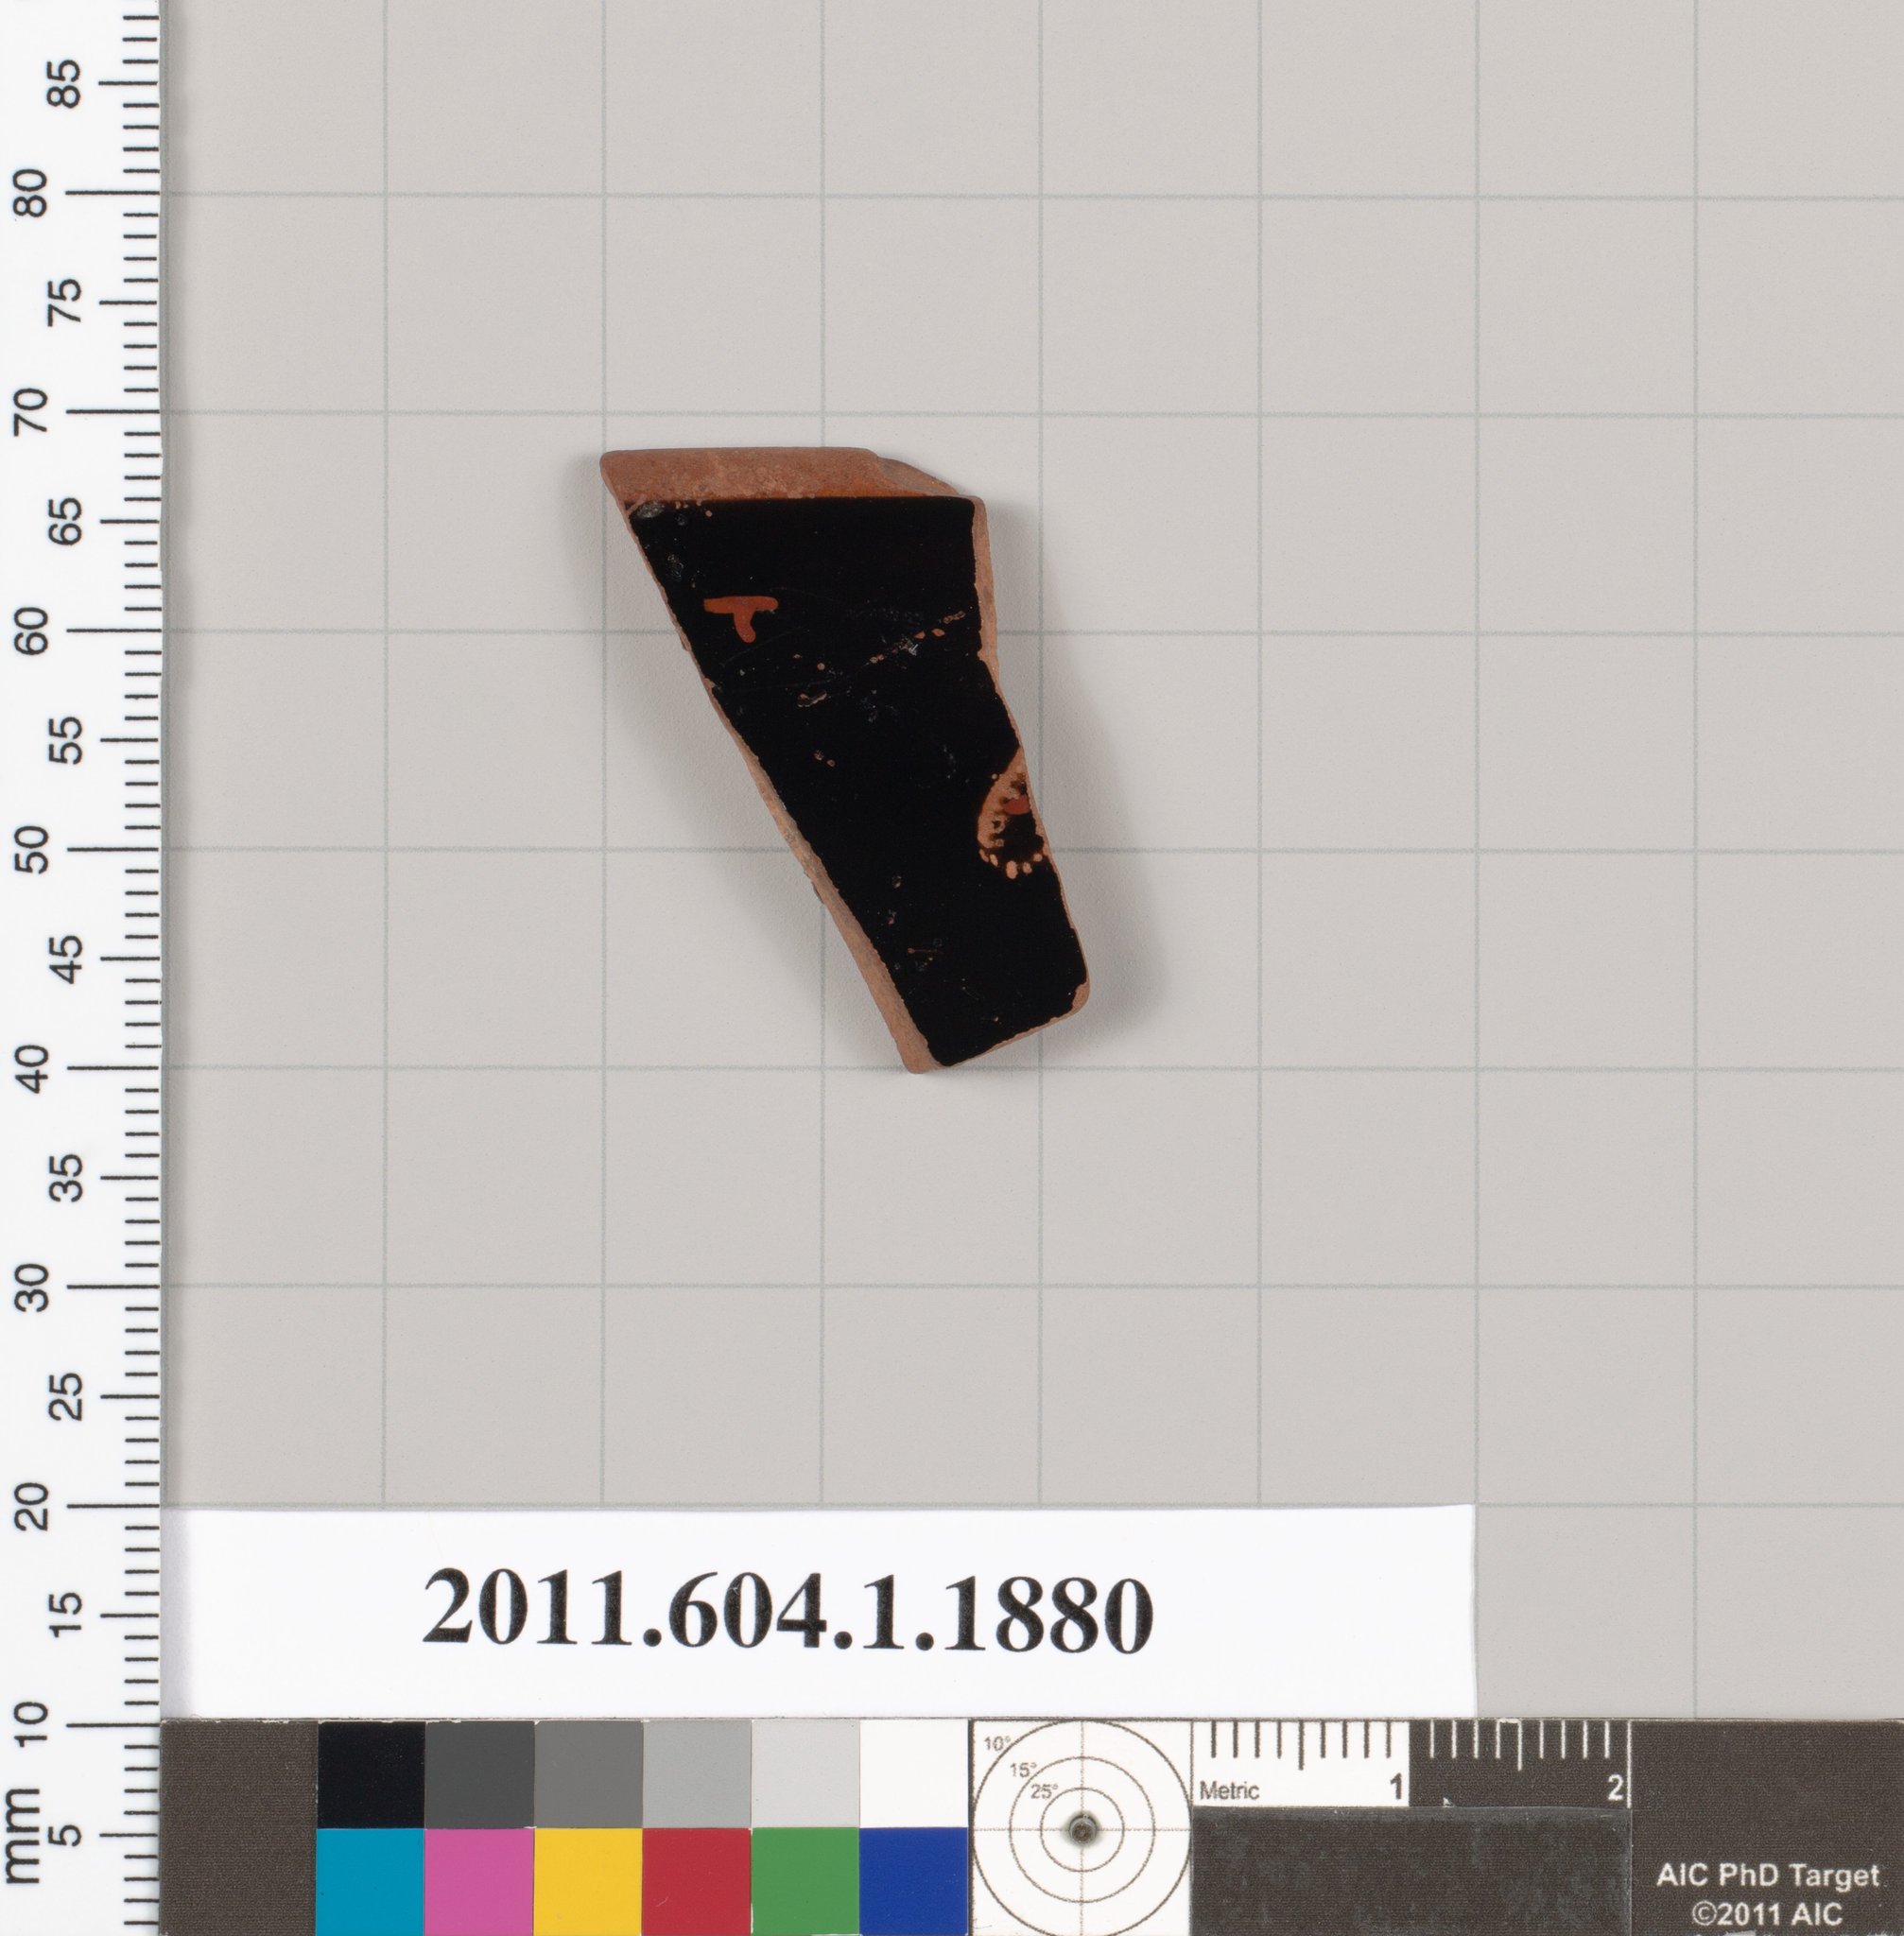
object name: kylix fragment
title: Terracotta rim fragment of a kylix (drinking cup)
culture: greek, attic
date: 490-470 BCE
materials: terracotta